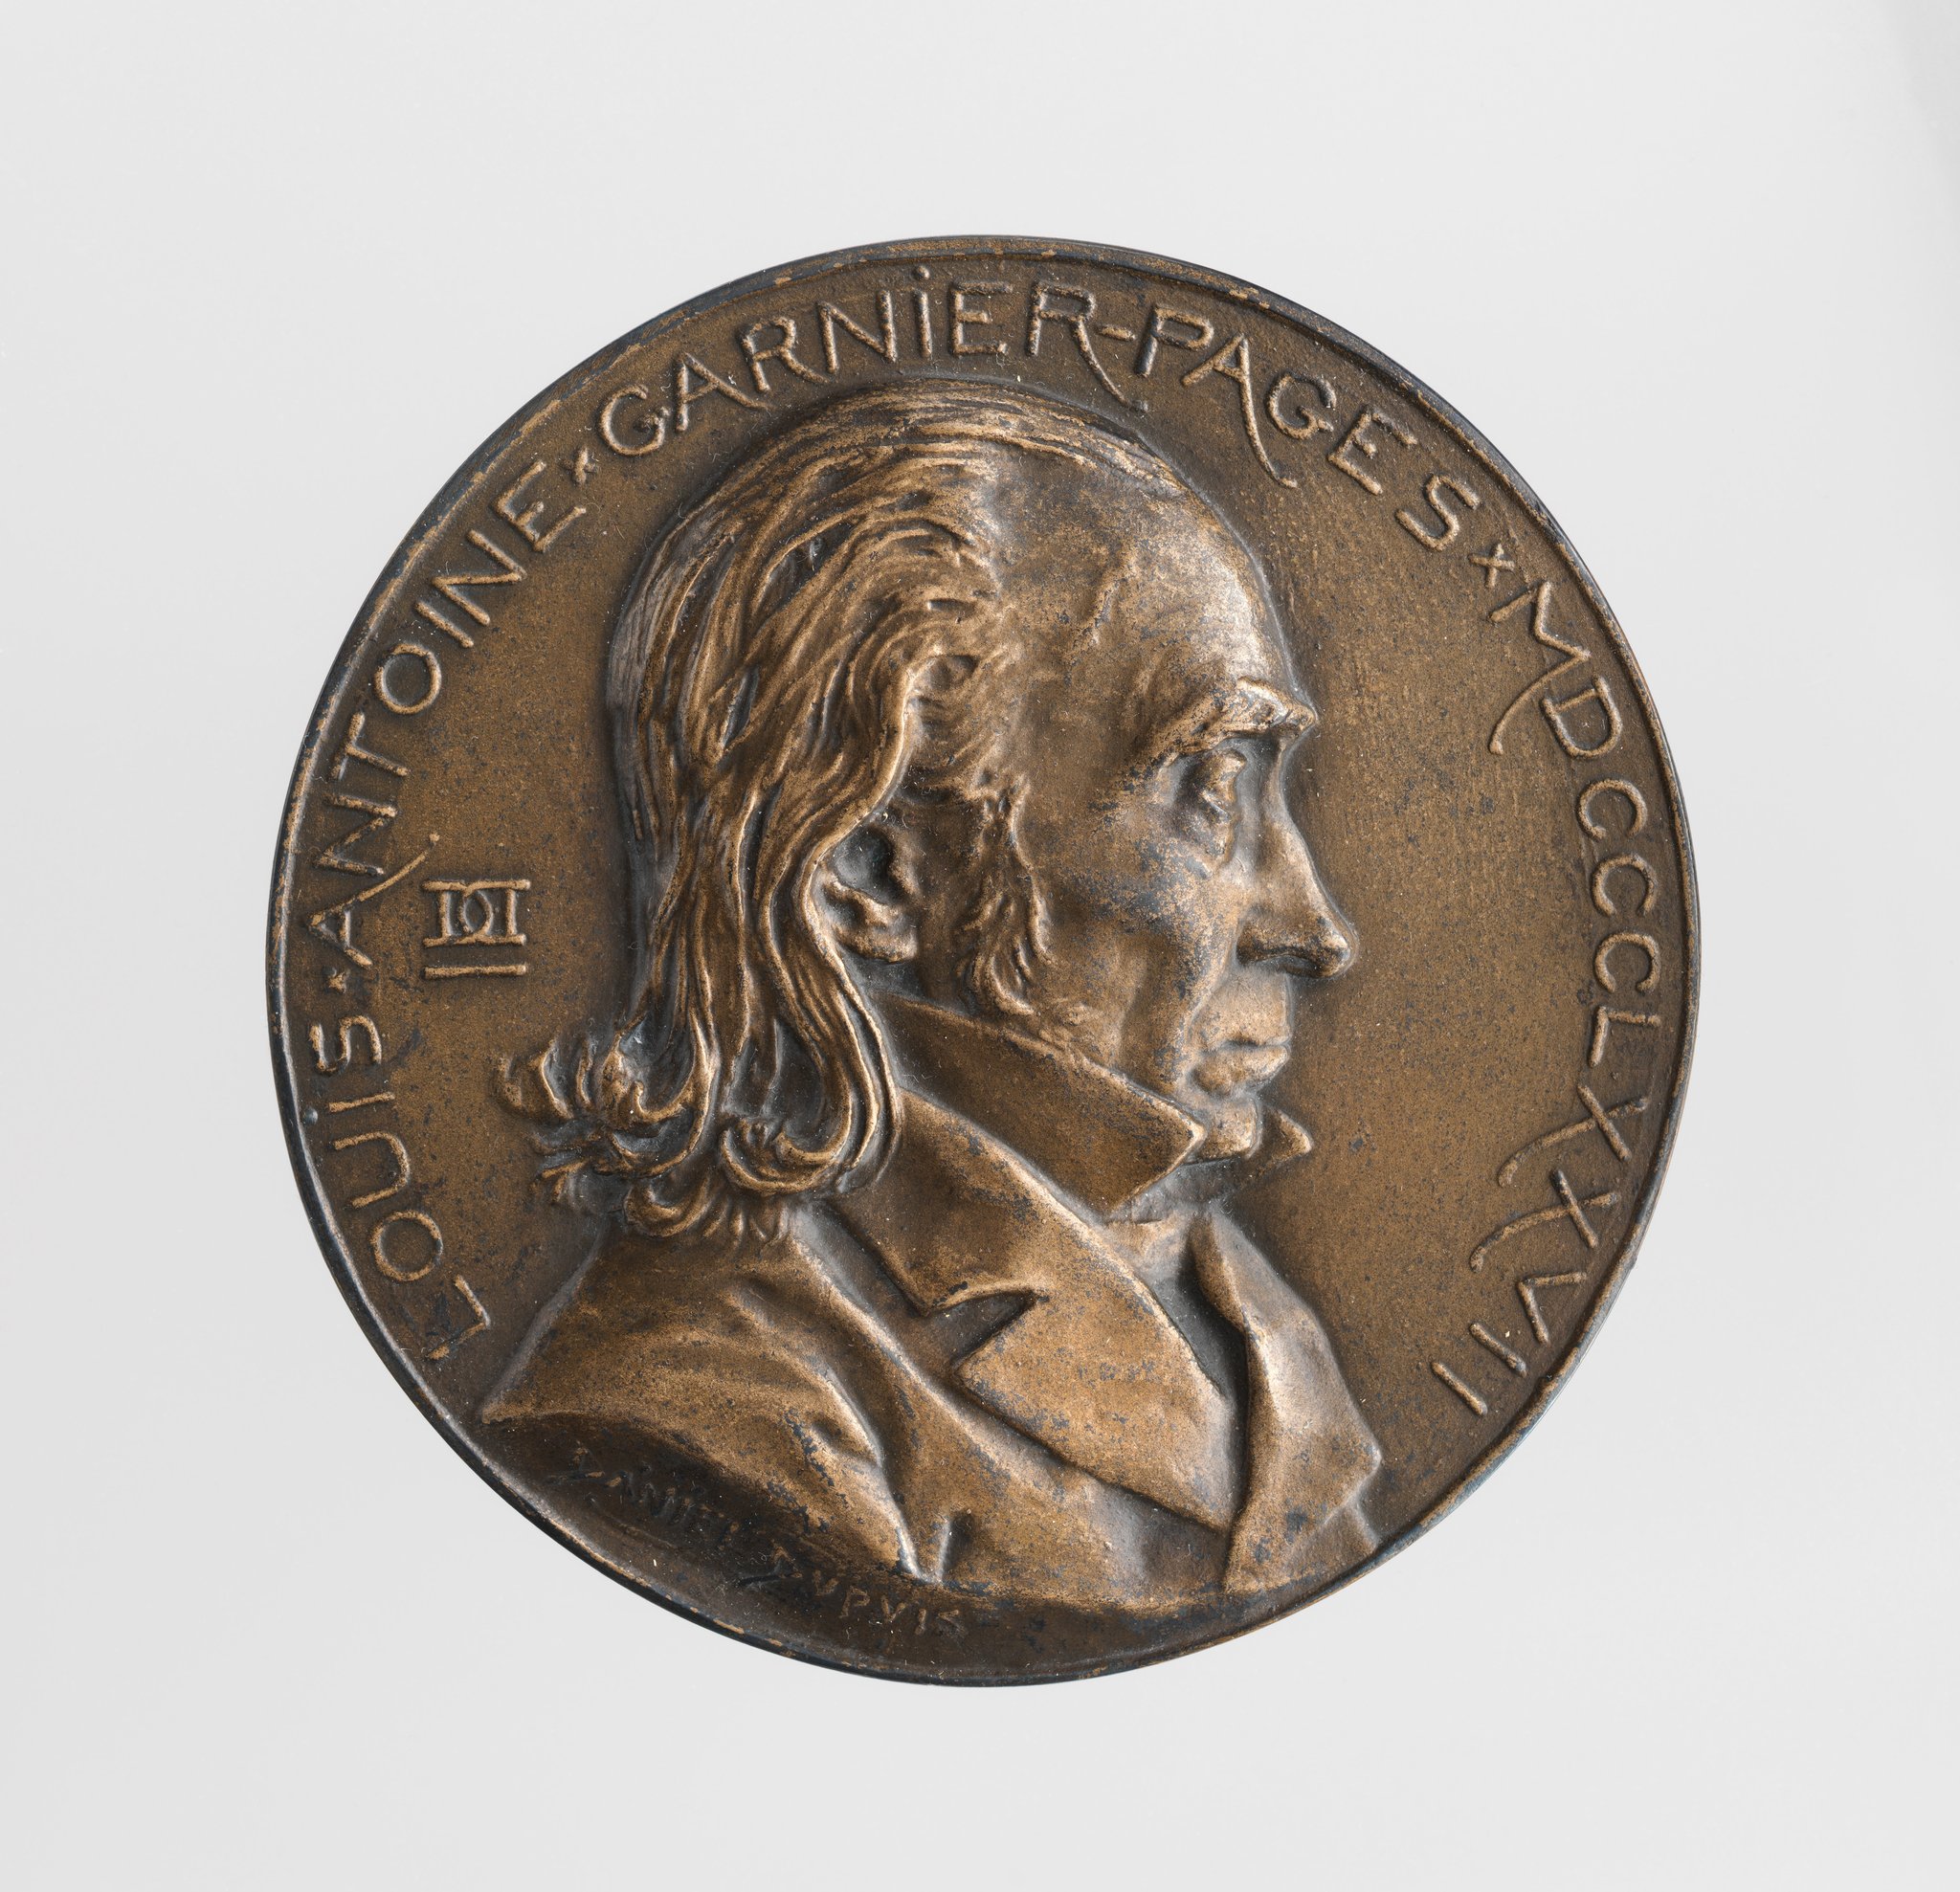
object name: medallion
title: Louis-Antoine Garnier-Pages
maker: daniel jean-baptiste dupuis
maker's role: artist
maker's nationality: french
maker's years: 1849-1899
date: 1877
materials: bronze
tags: men,profiles